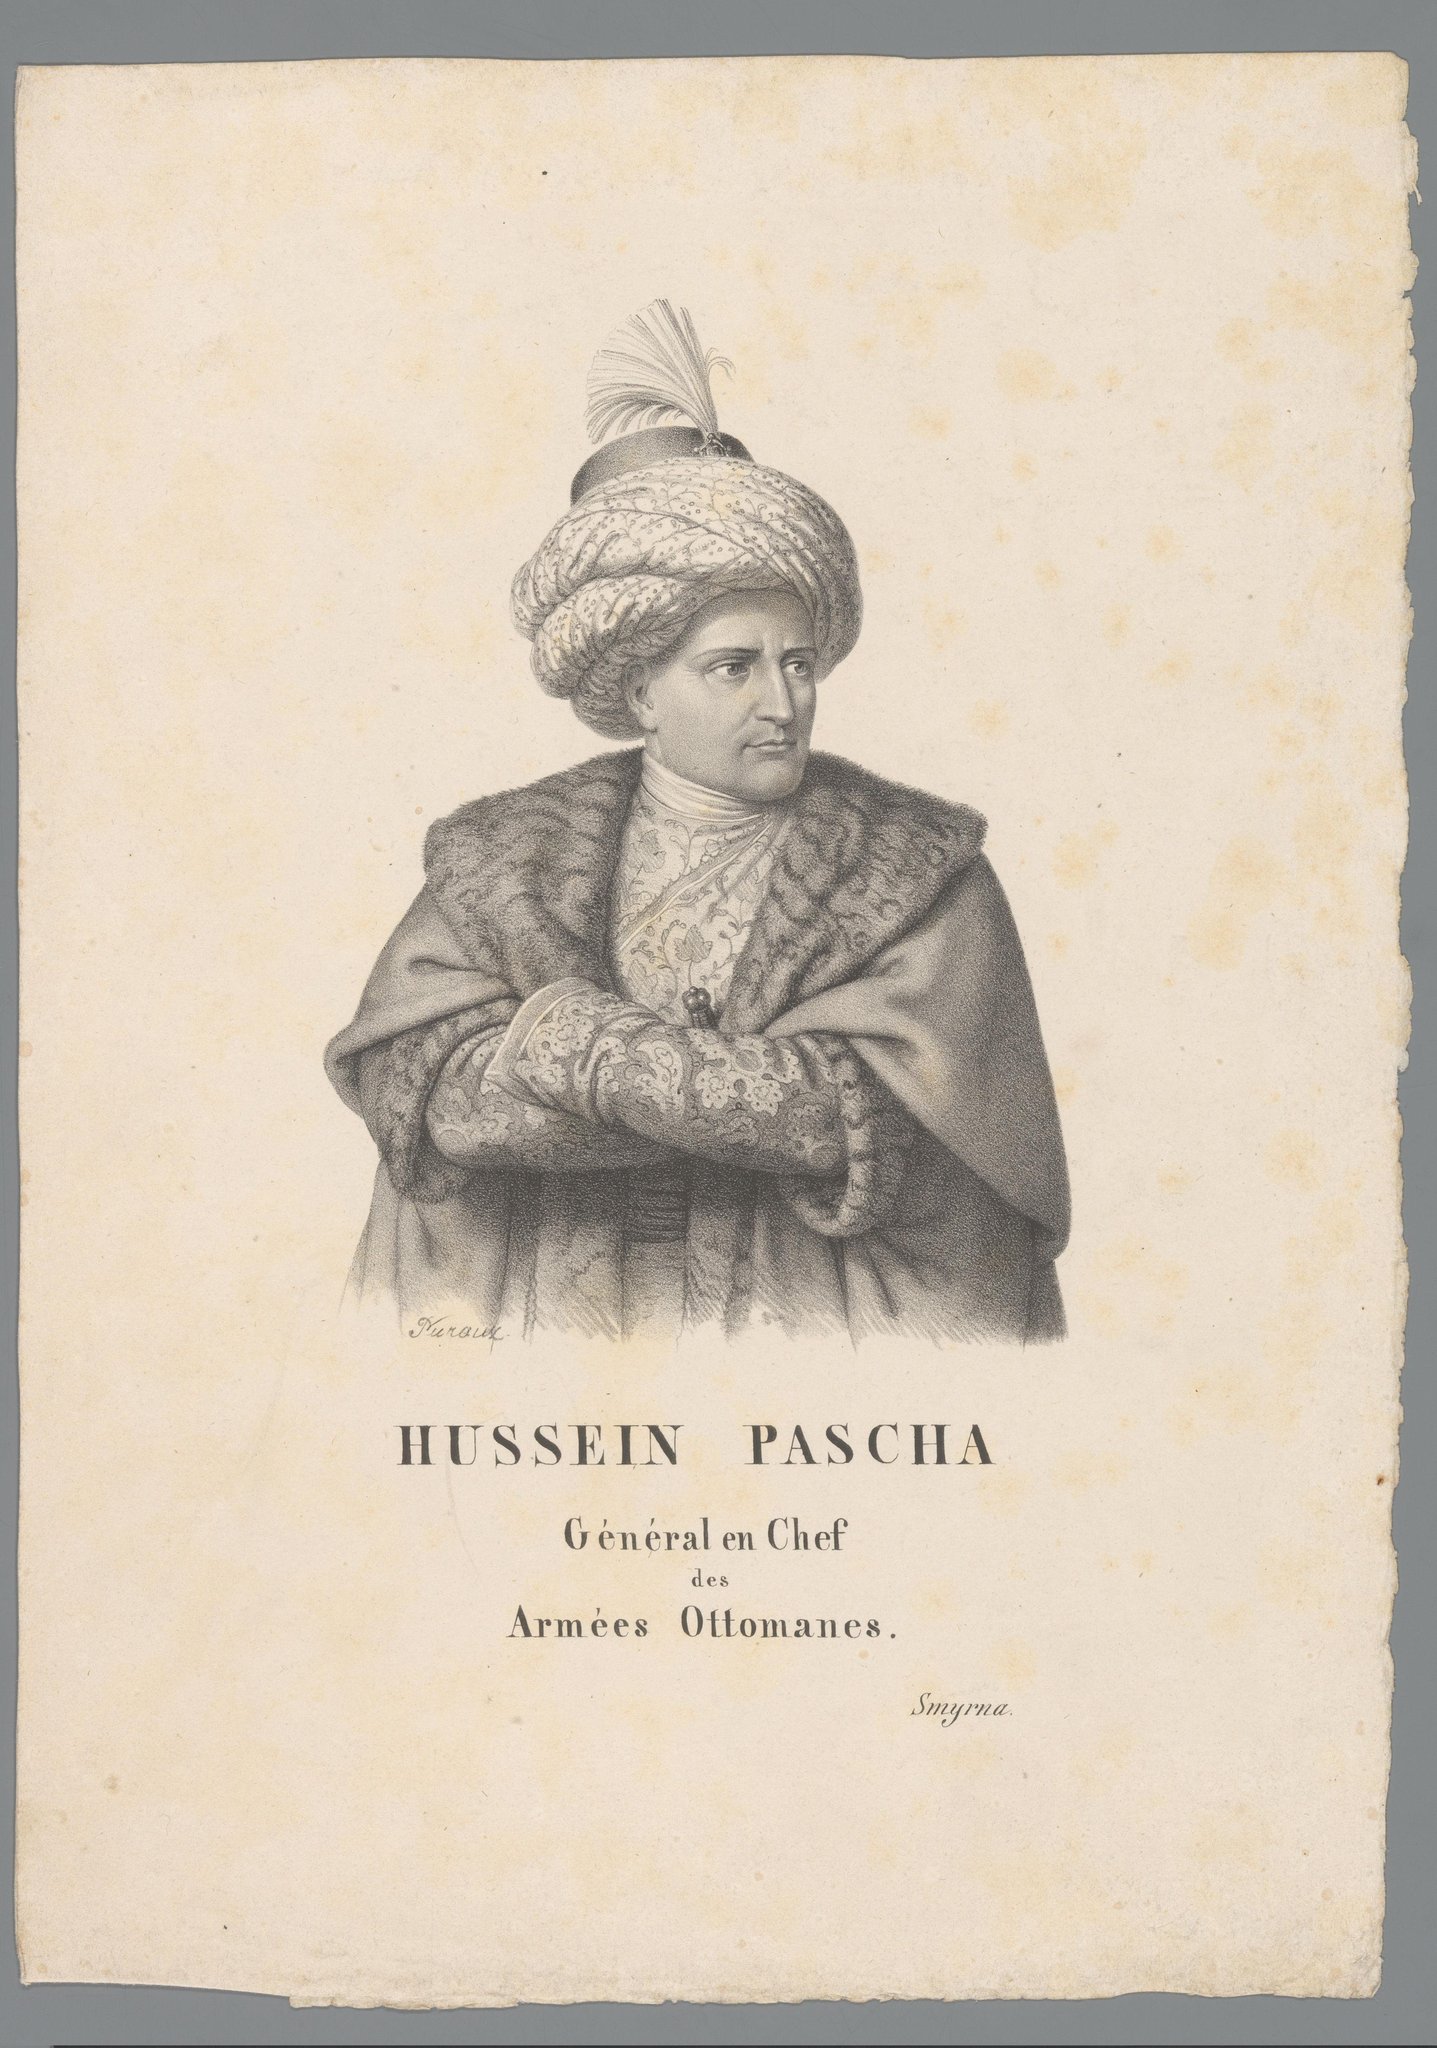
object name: print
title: Smyrna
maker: puraux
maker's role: print maker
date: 1820-1840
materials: paper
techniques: lithograph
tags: historical persons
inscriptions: collector's mark: Lugt 2228